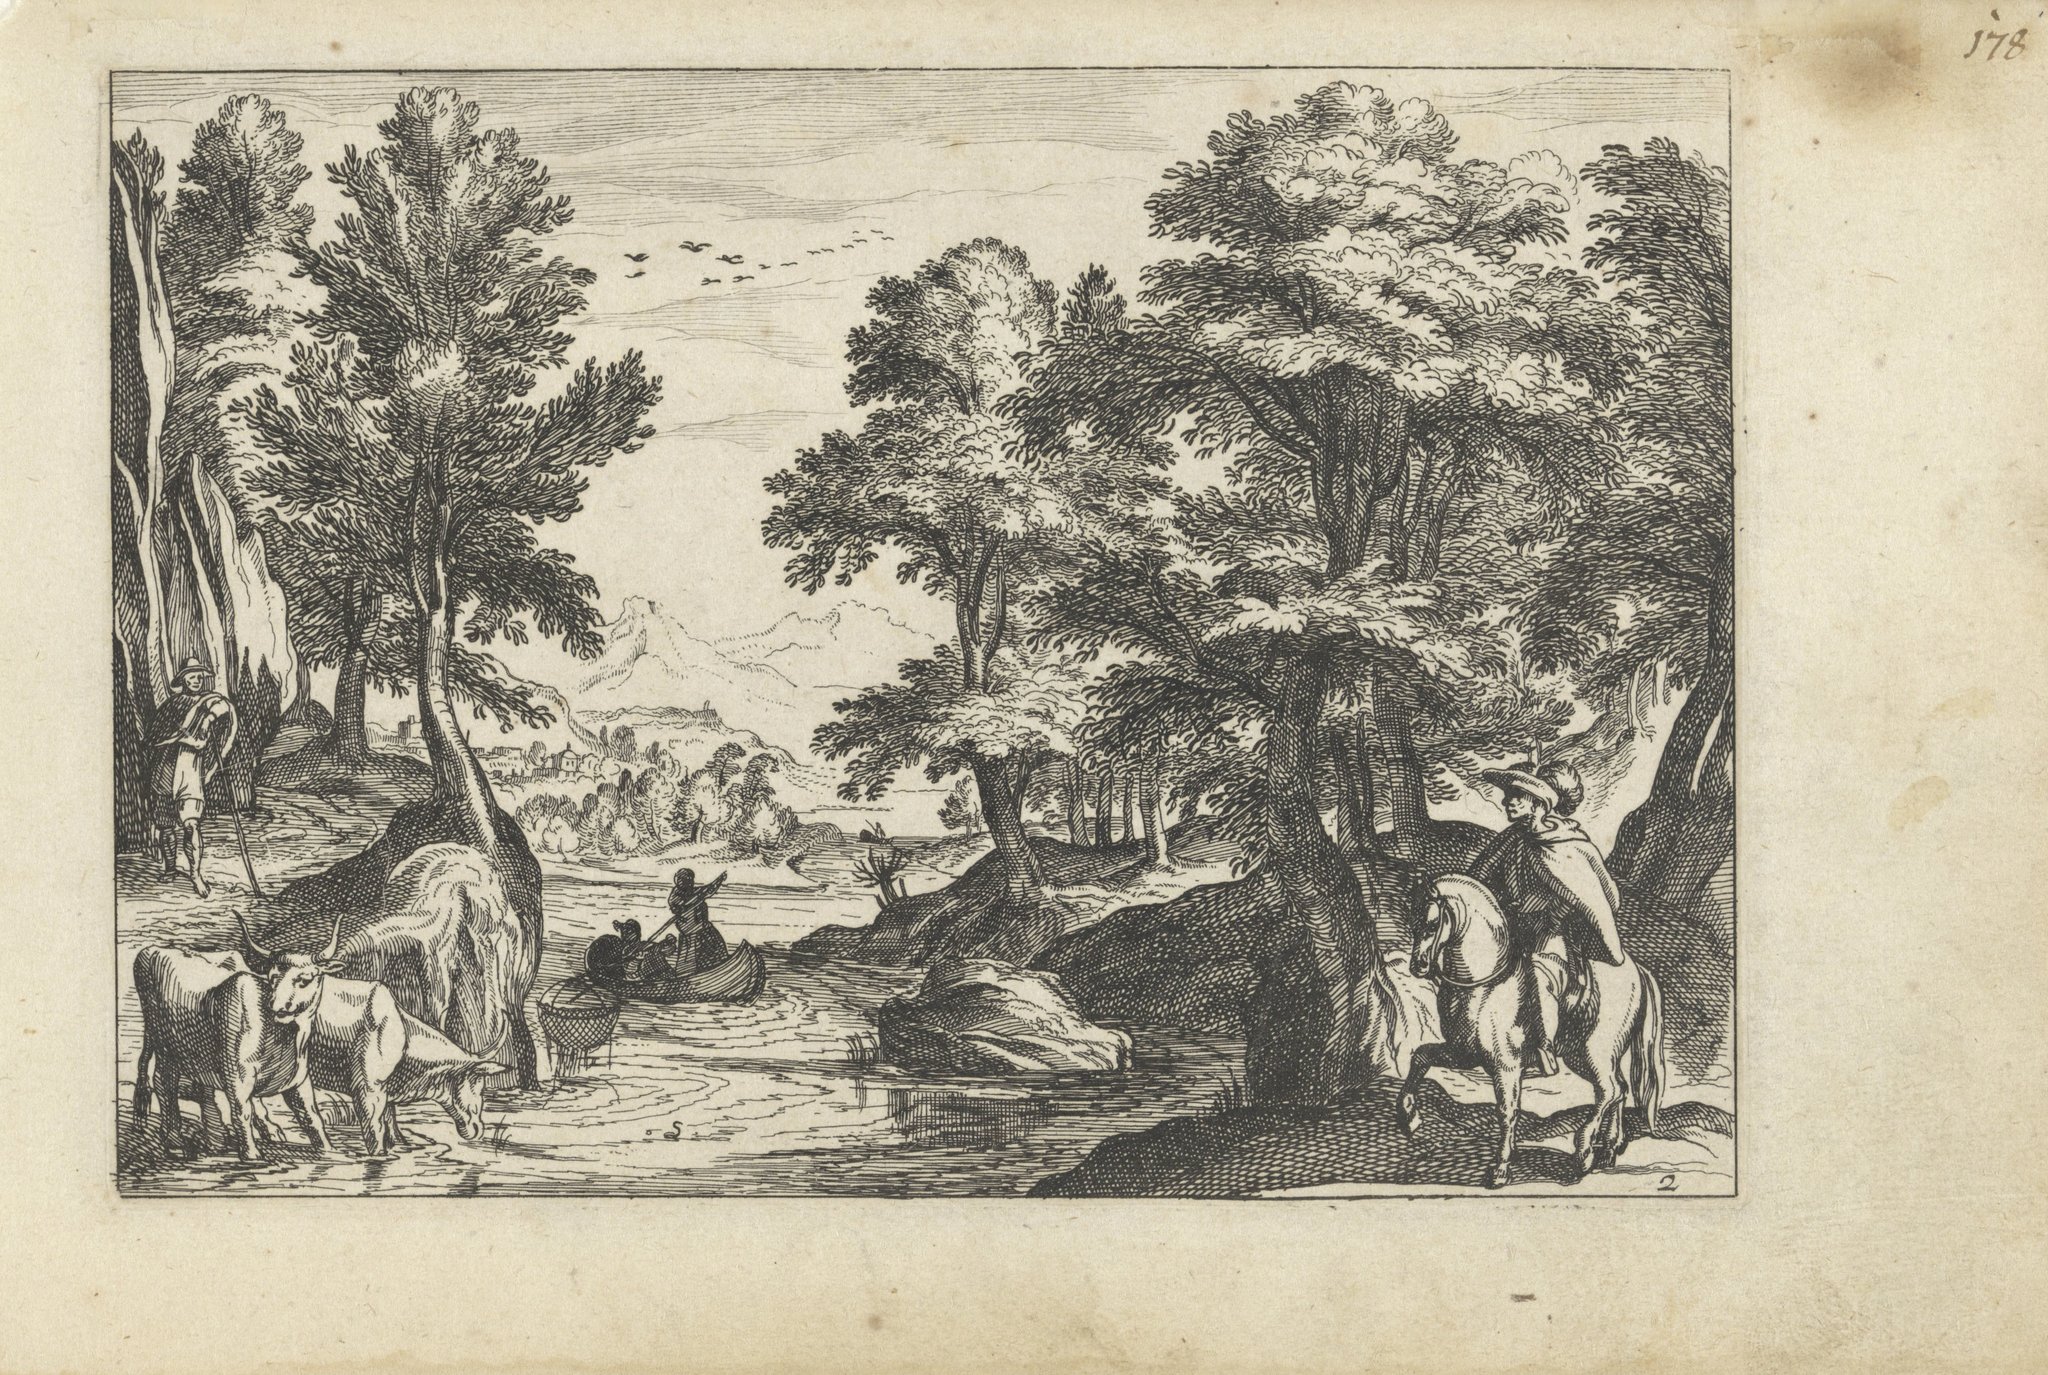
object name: print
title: Landschap met ruiter, drinkend vee en een bootje in een rivier.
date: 1612-1652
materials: paper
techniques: engraving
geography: netherlands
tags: river, forest, wood, mountains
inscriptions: collector's mark: Lugt 2228, collector's mark: 2760, number: ‘2’ Lugt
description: Boslandschap met een ruiter, drinkend vee en een vissersbootje in een rivier. Op de achtergrond zijn bergen zichtbaar.